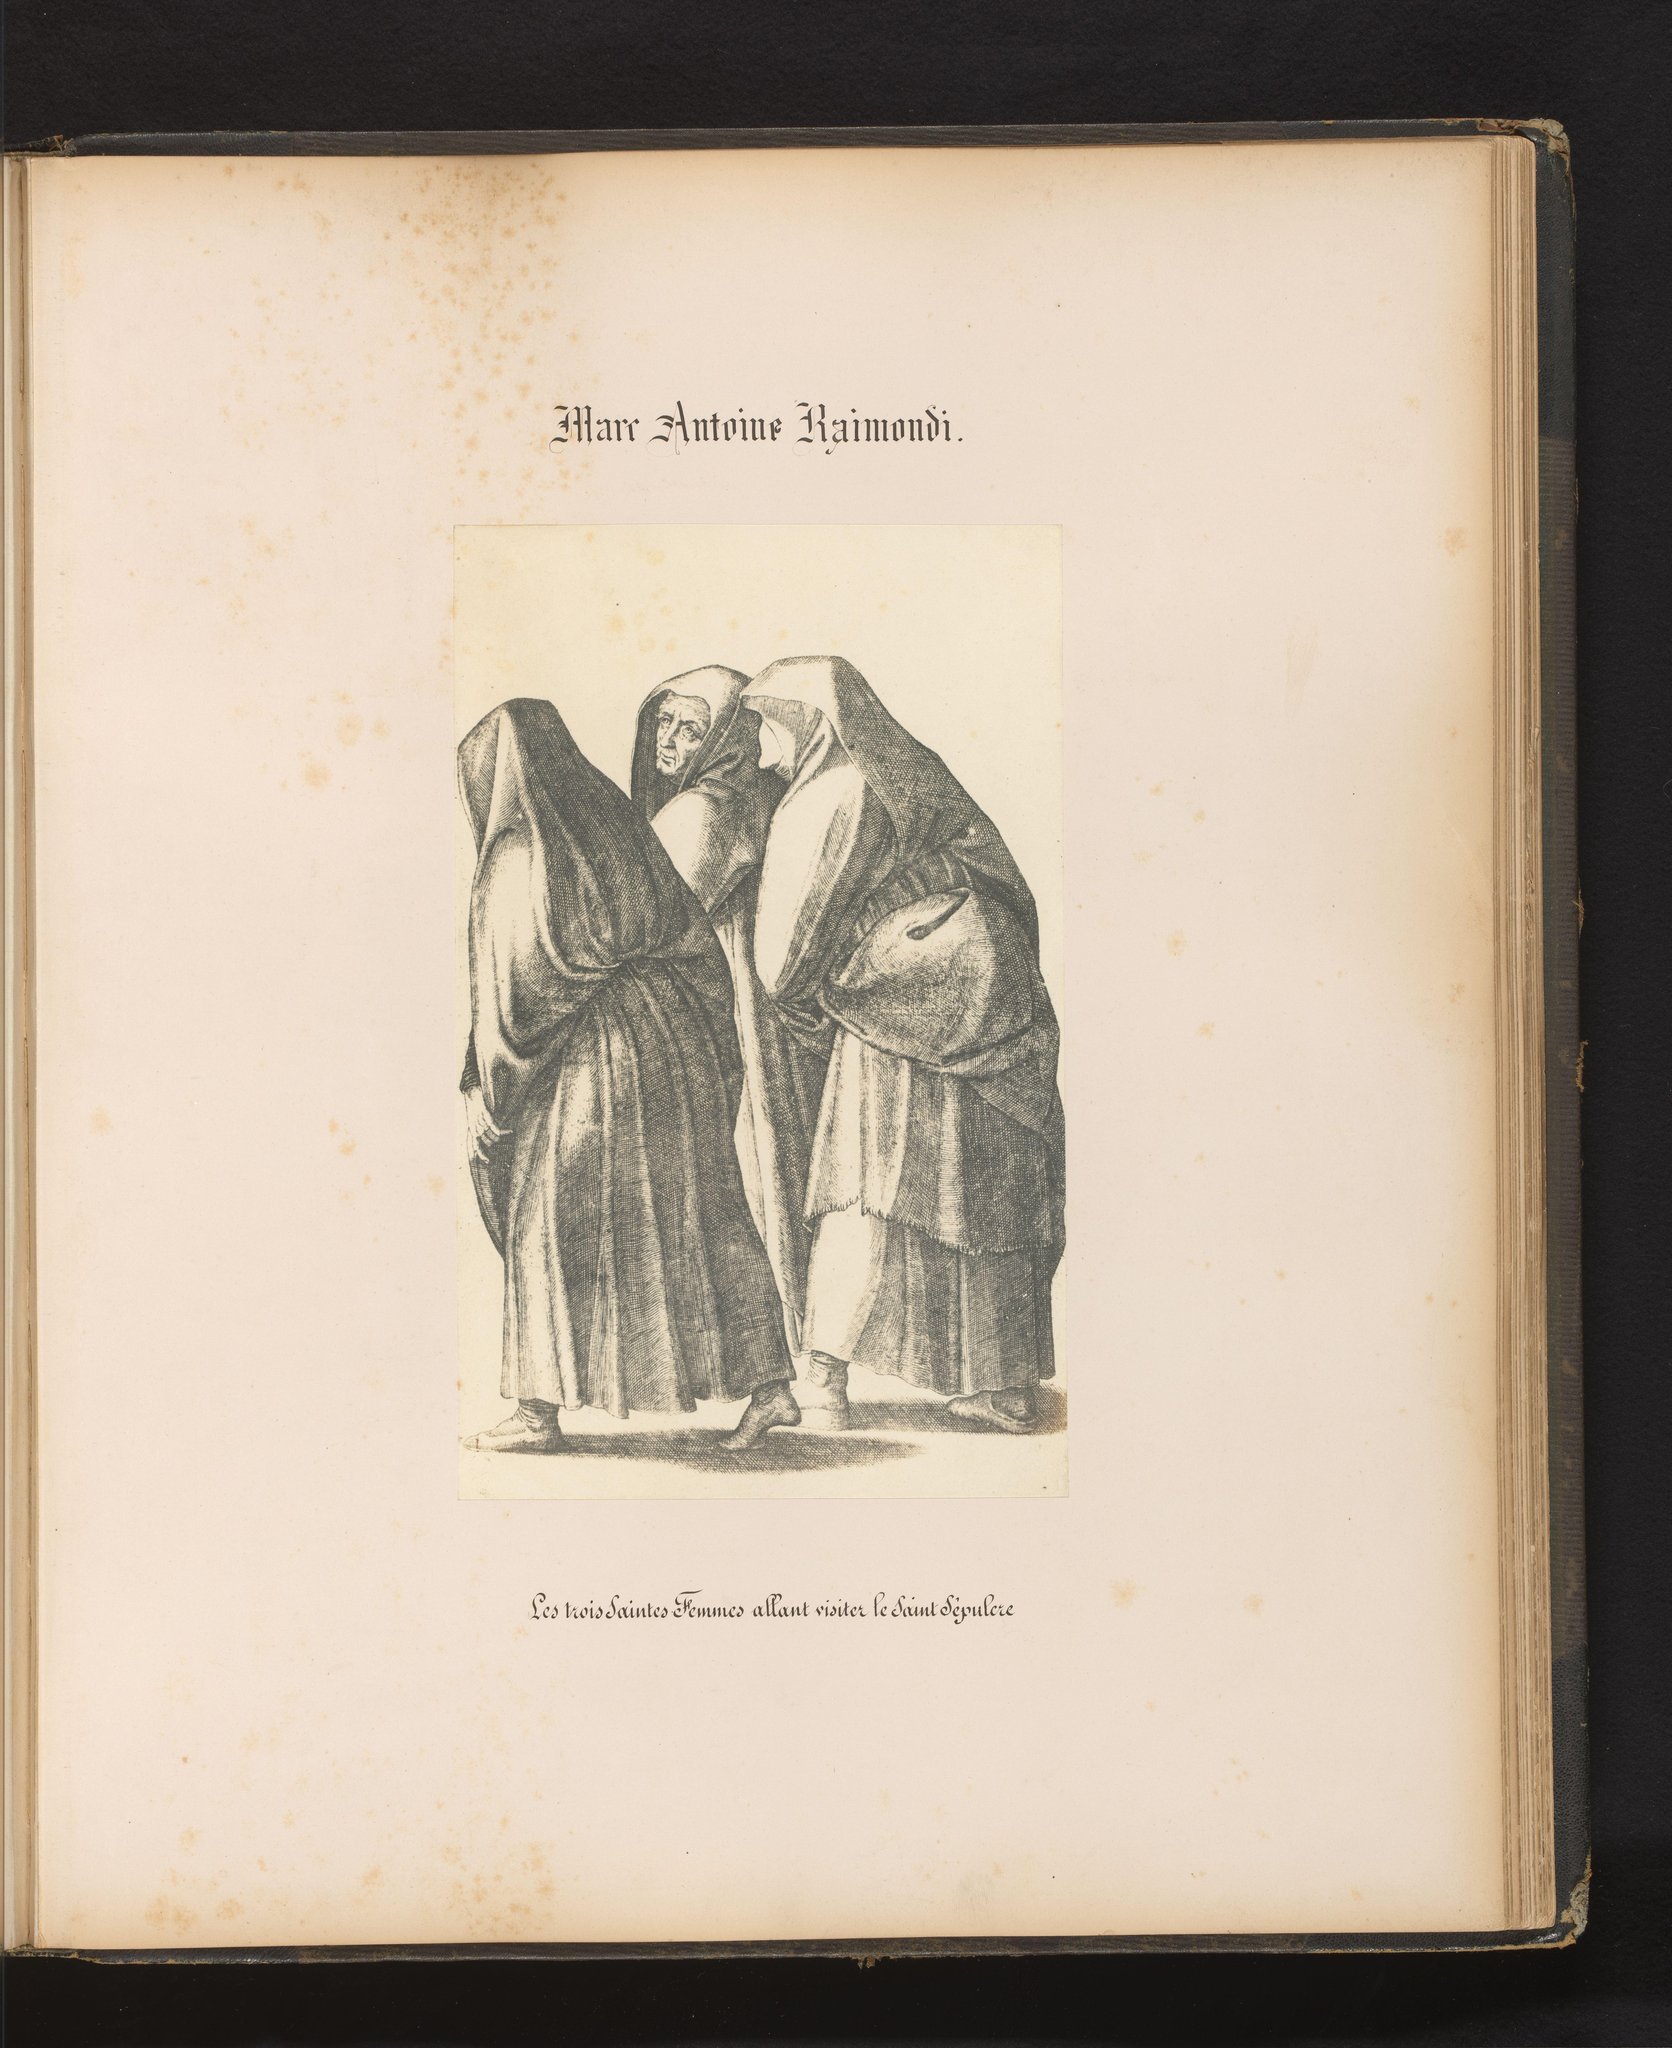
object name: photograph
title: Les trois Saintes Femmes allant visiter le Saint Sépulcre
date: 1848-1853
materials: photographic support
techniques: salted paper print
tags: the holy women (the three maries) on their way to or at the tomb, to anoint christ's body